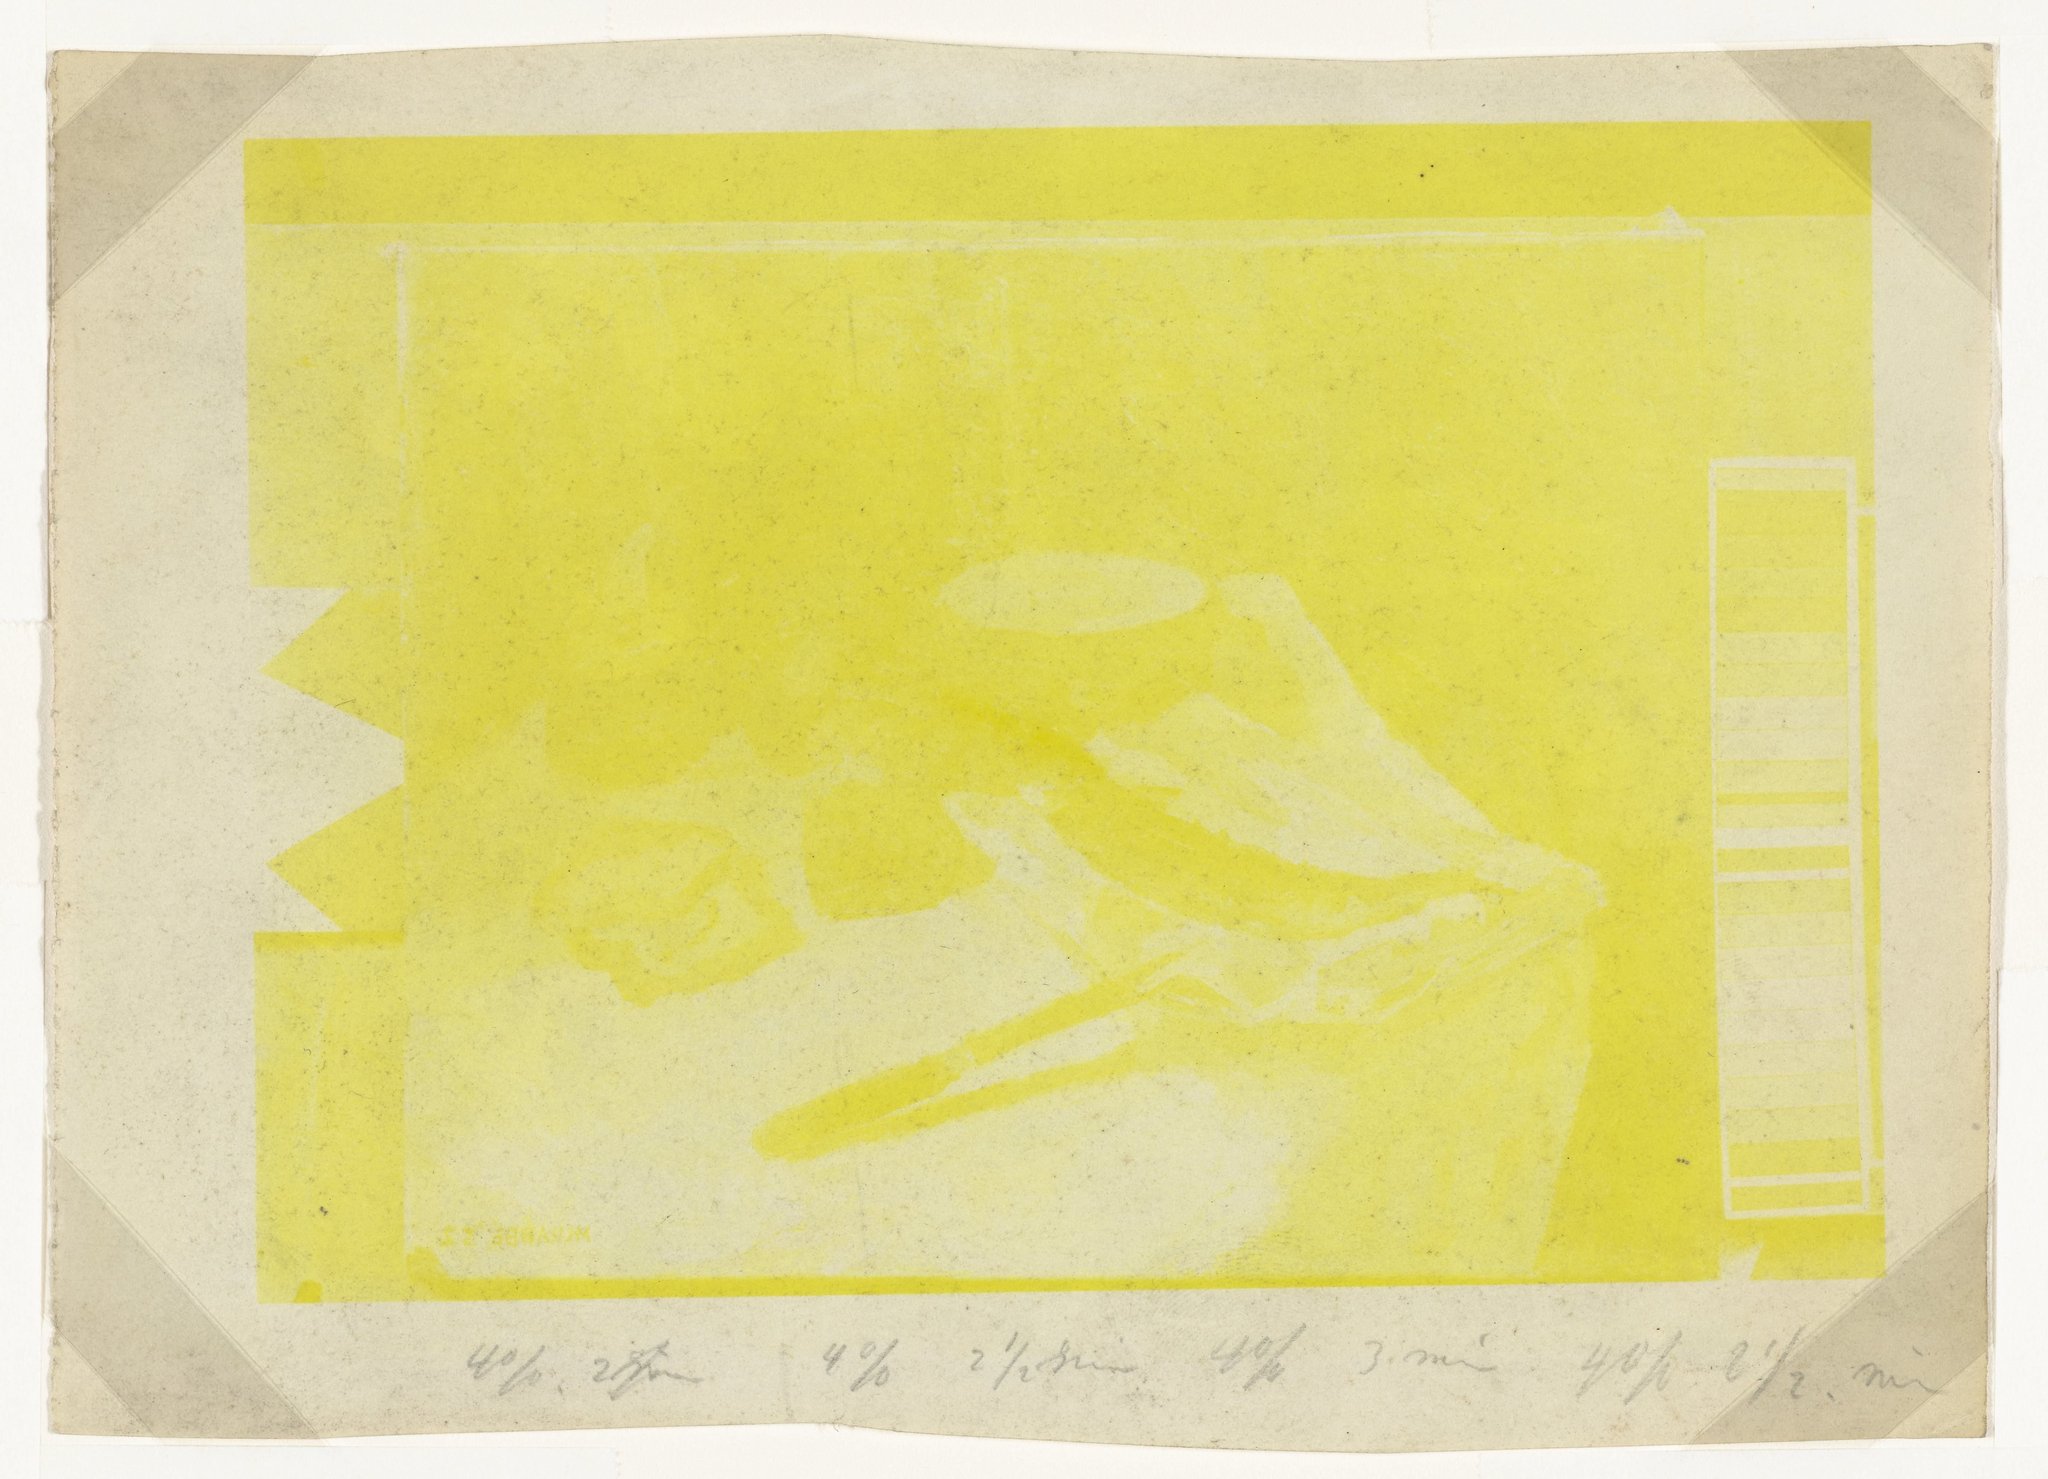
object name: photograph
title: Stilleven door schilder Krabbé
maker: jacob merkelbach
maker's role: fotograaf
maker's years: 1877-1942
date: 1925-1930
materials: paper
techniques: carbro process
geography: amsterdam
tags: still life of related objects